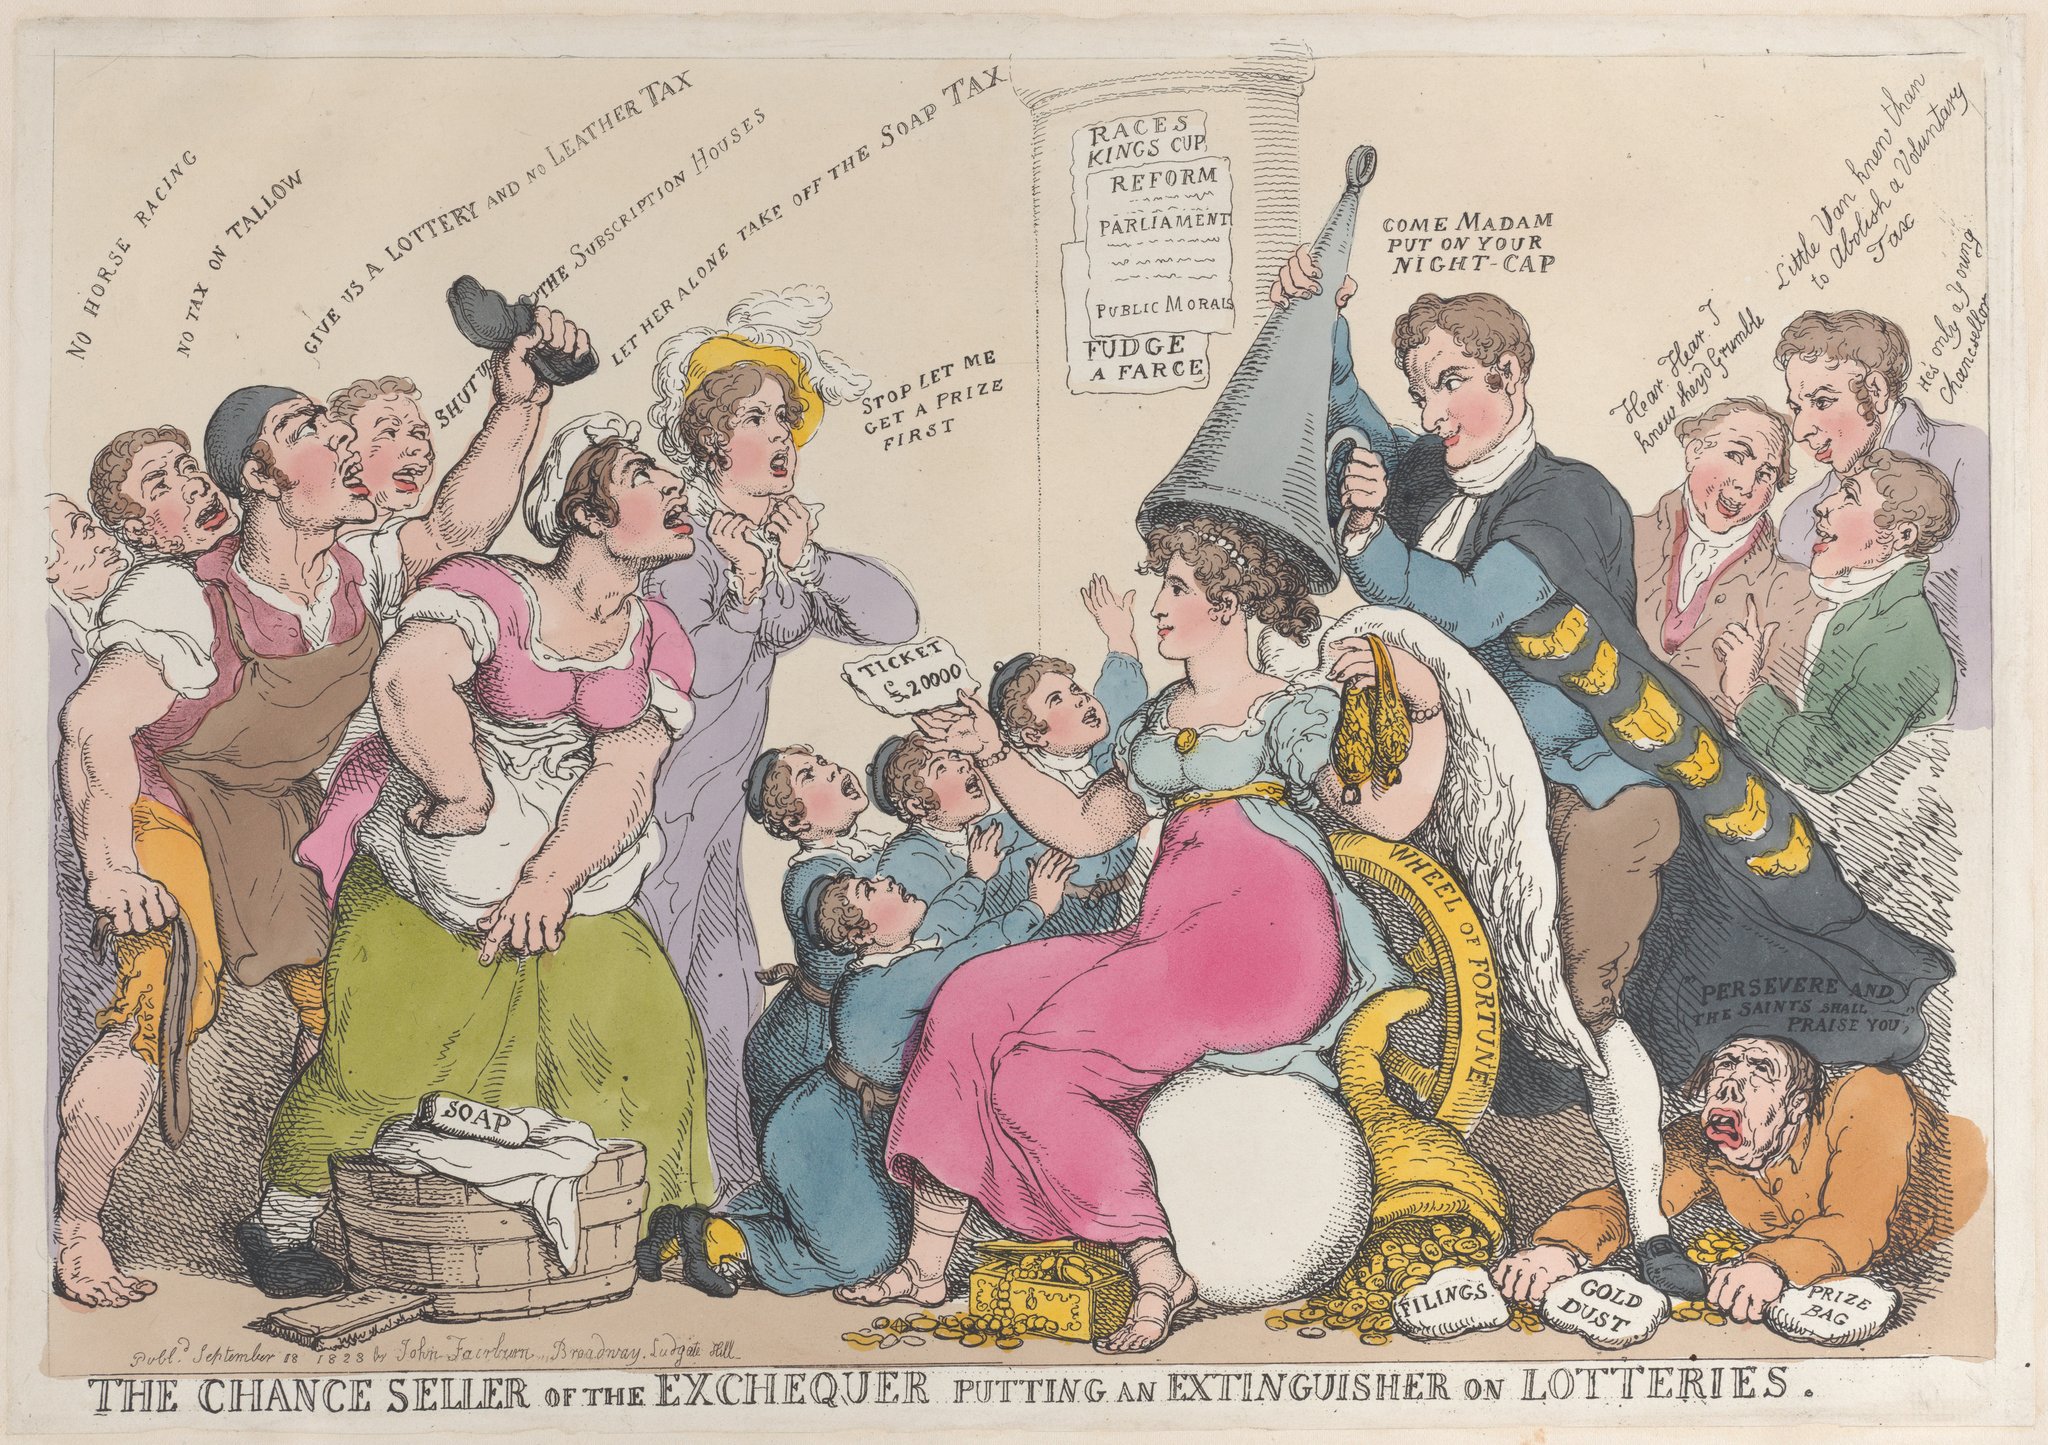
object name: print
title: The Chance Seller of the Exchequer Putting an Extinguisher on Lotteries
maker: thomas rowlandson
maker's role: artist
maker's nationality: british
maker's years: 1757-1827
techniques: etching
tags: satire,men,women,politics